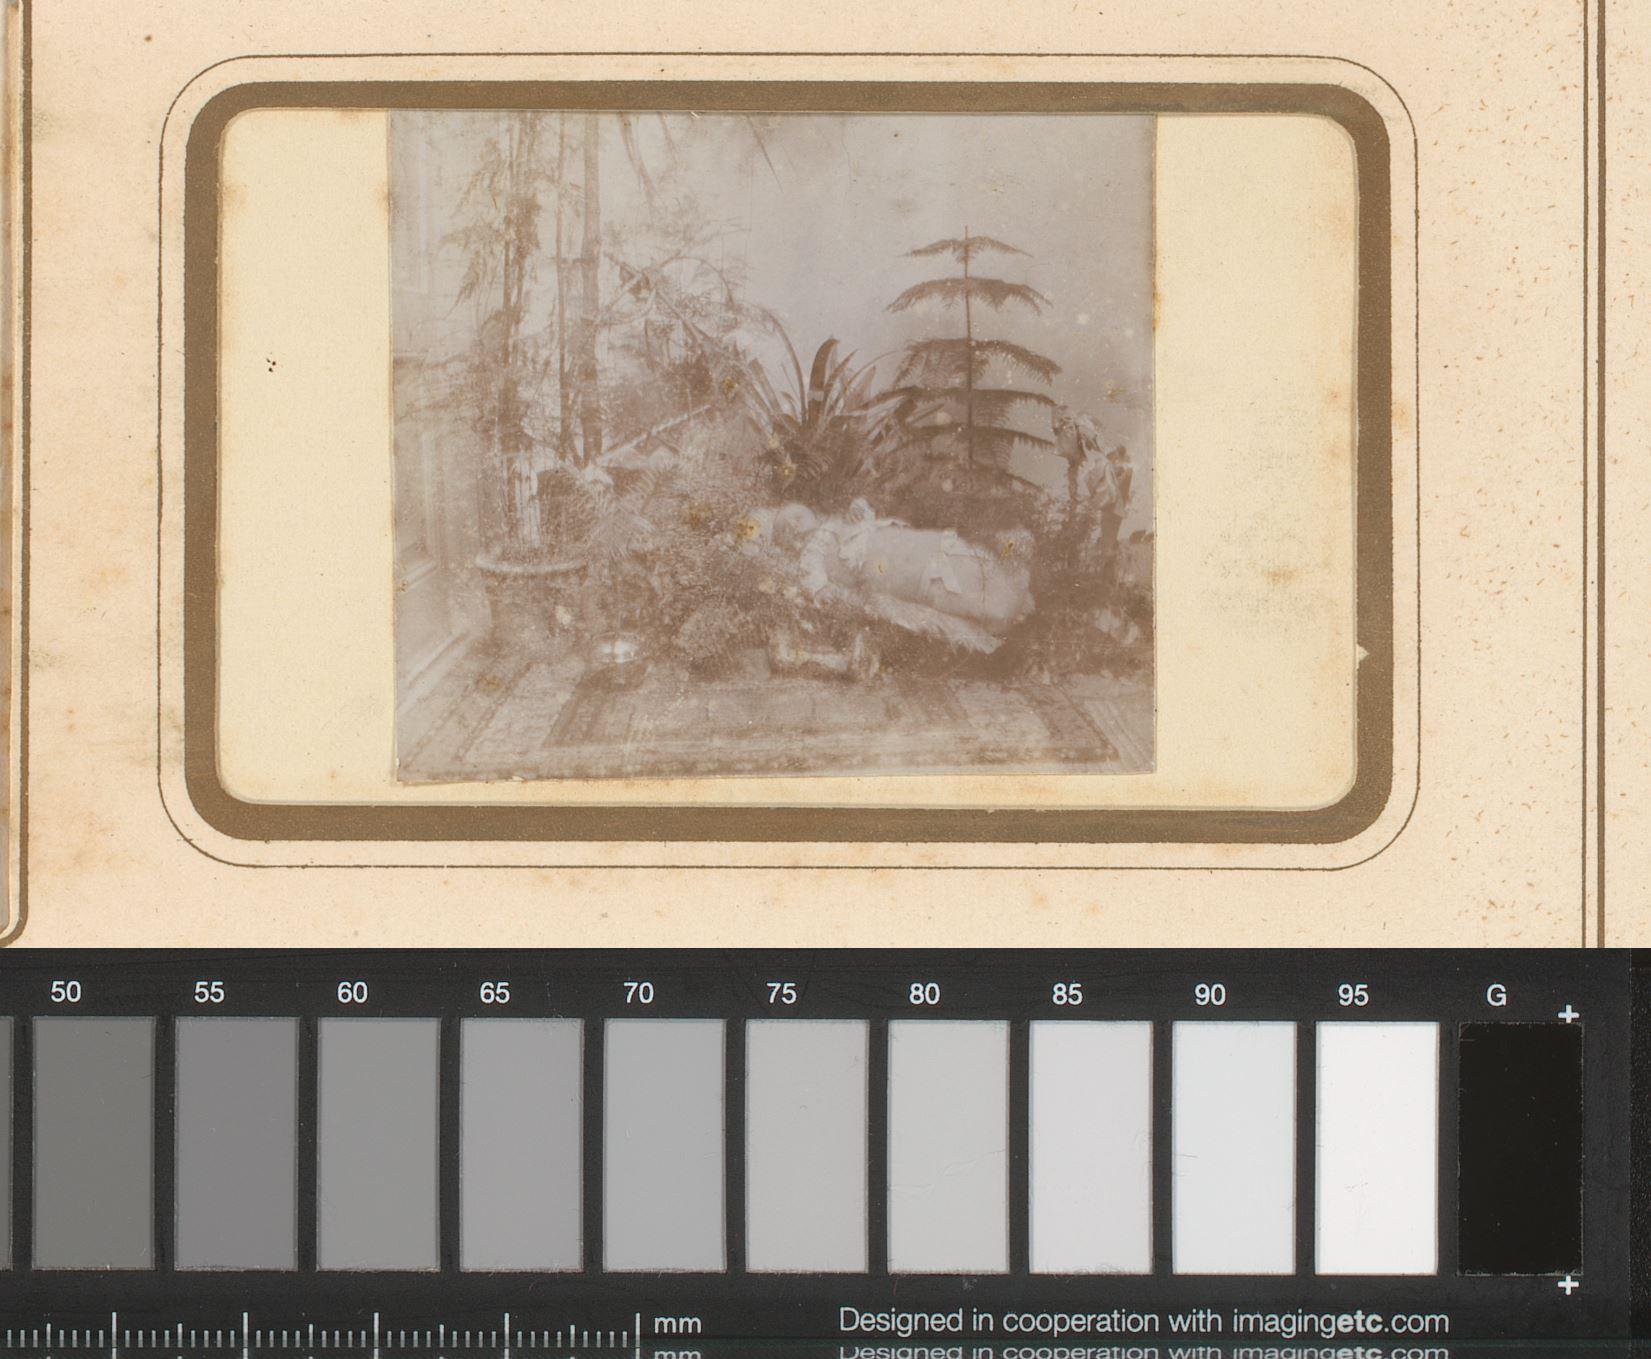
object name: album leaf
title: Gezicht op een tuin met een wieg en baby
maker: Anonymous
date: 1880-1920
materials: cardboard, photographic support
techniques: collodion silver print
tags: garden, infant, baby